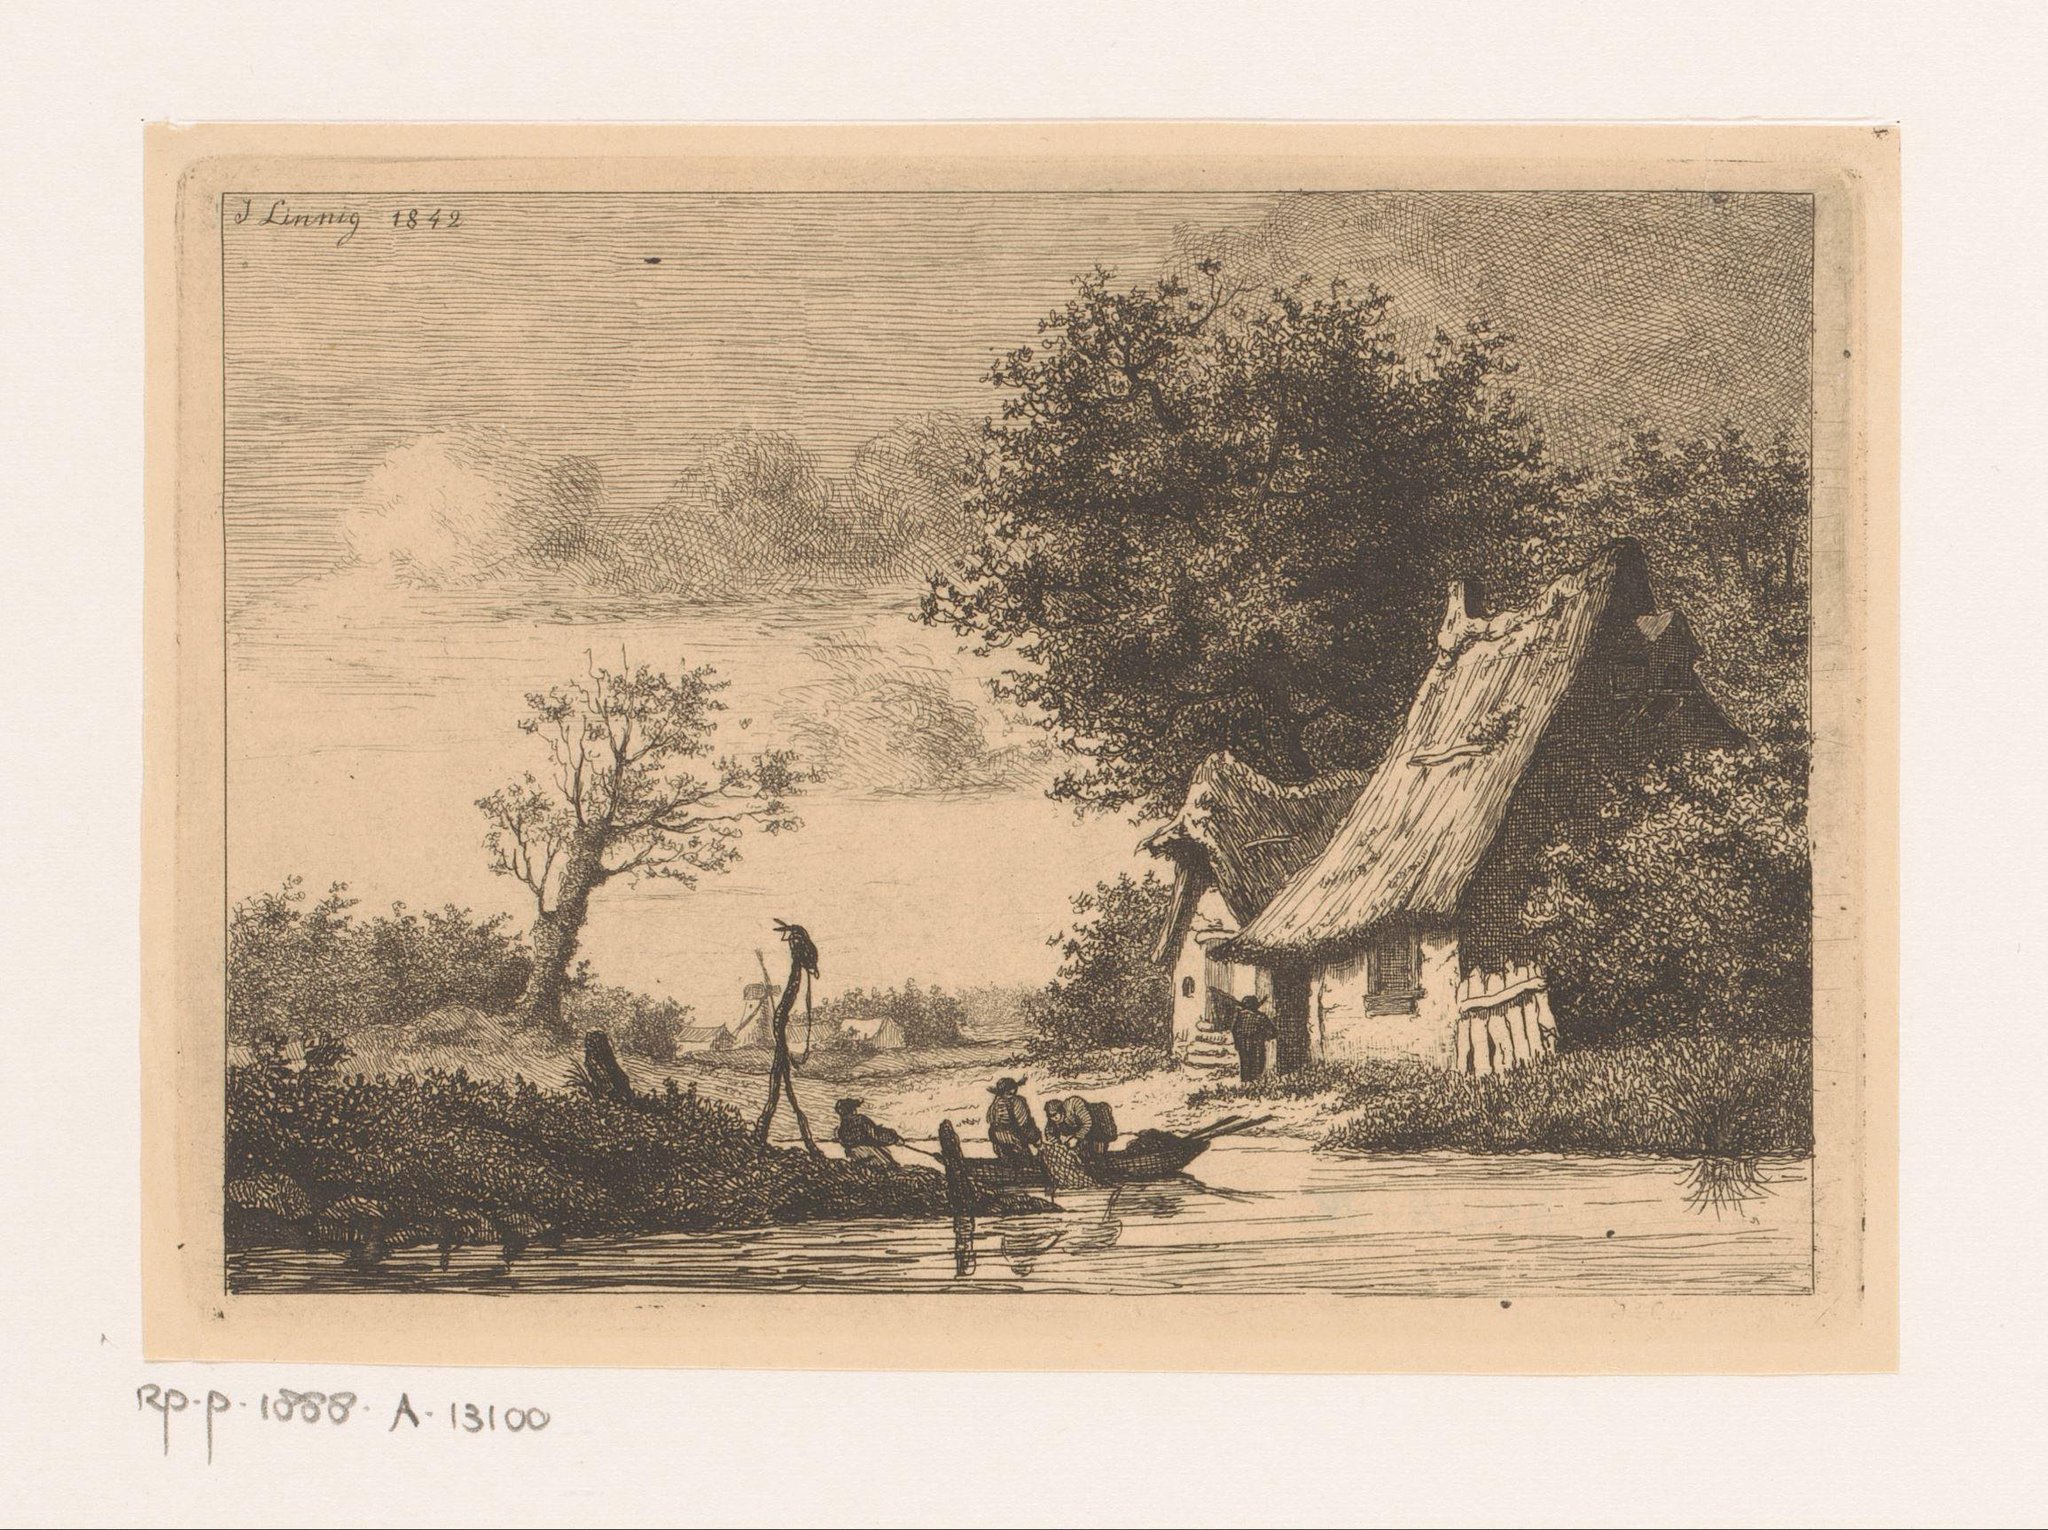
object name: print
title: Riviergezicht met vissers bij Kruibeke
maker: jean théodore joseph linnig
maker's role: draughtsman, print maker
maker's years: 1815-1891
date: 1842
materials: paper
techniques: etching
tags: river, rowing-boat, canoe, etc., farm or solitary house in landscape, antwerp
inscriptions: collector's mark: Lugt 2228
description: Voor de ontwerptekening voor deze ets, zie RP-T-1912-6.